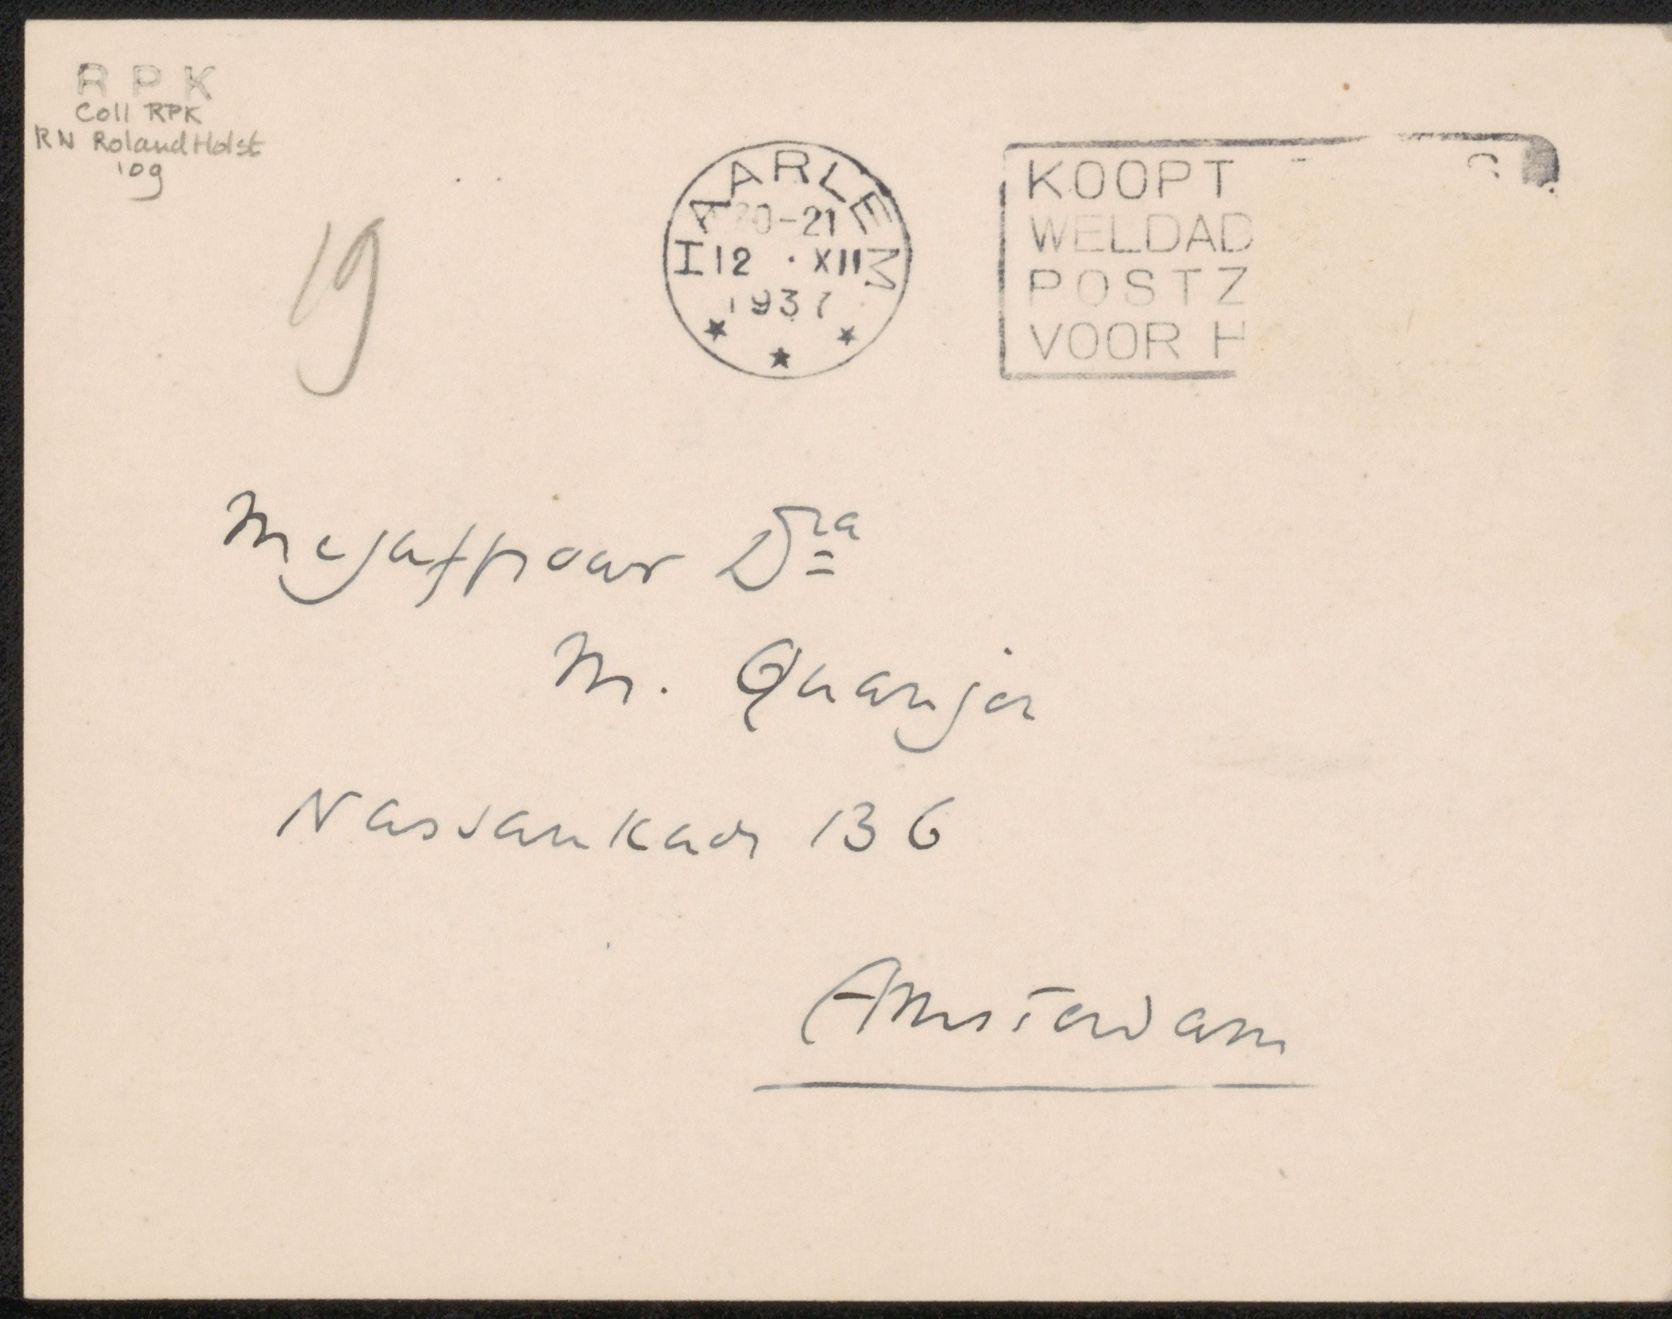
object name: letter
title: Brief aan Marisa Quanjer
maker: richard nicolaüs roland holst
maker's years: 1868-1938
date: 1937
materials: ink, paper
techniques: pen, writing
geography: haarlem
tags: historicus, kunsthistoricus, marisa quanjer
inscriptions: collector's mark: ‘RPK’